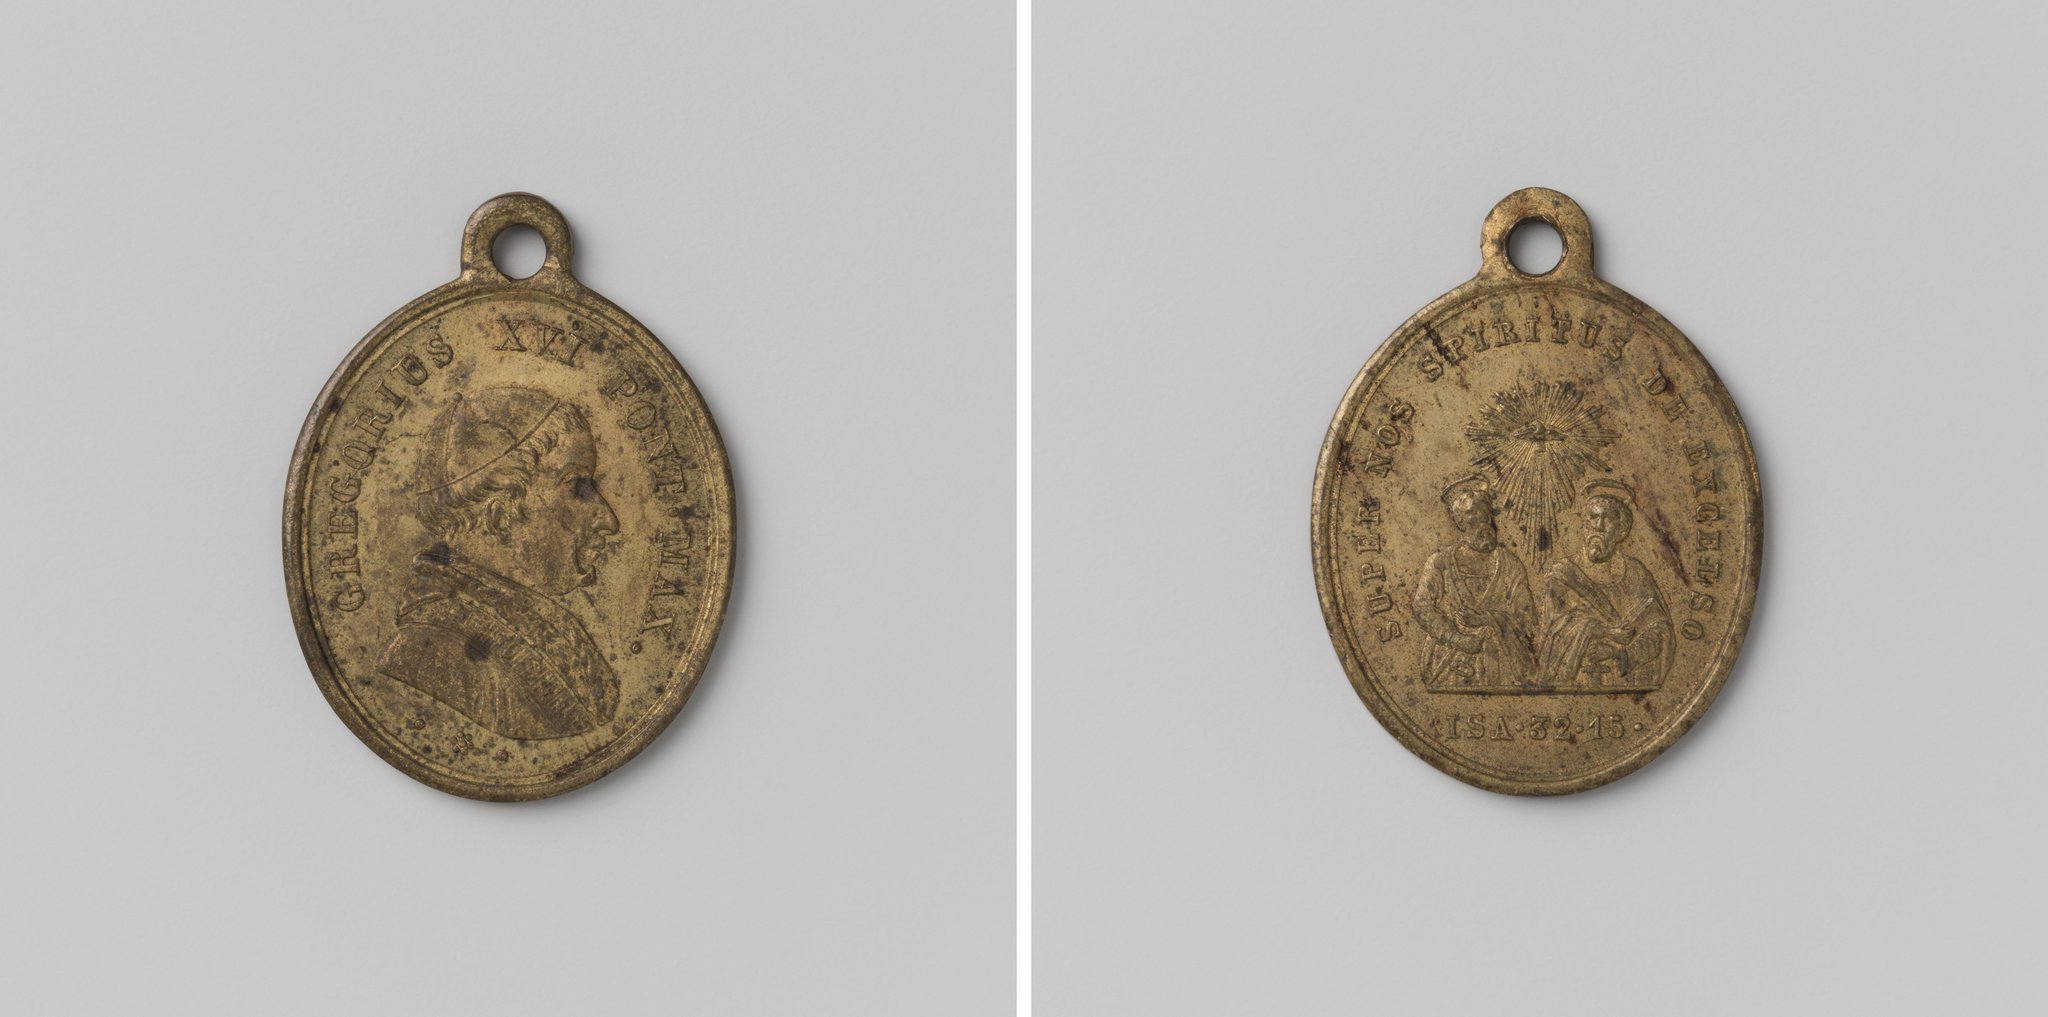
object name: devotional medal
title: Paus Gregorius XVI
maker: Anonymous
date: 1831-1846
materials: copper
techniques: striking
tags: belluno, paus, gregorius xvi